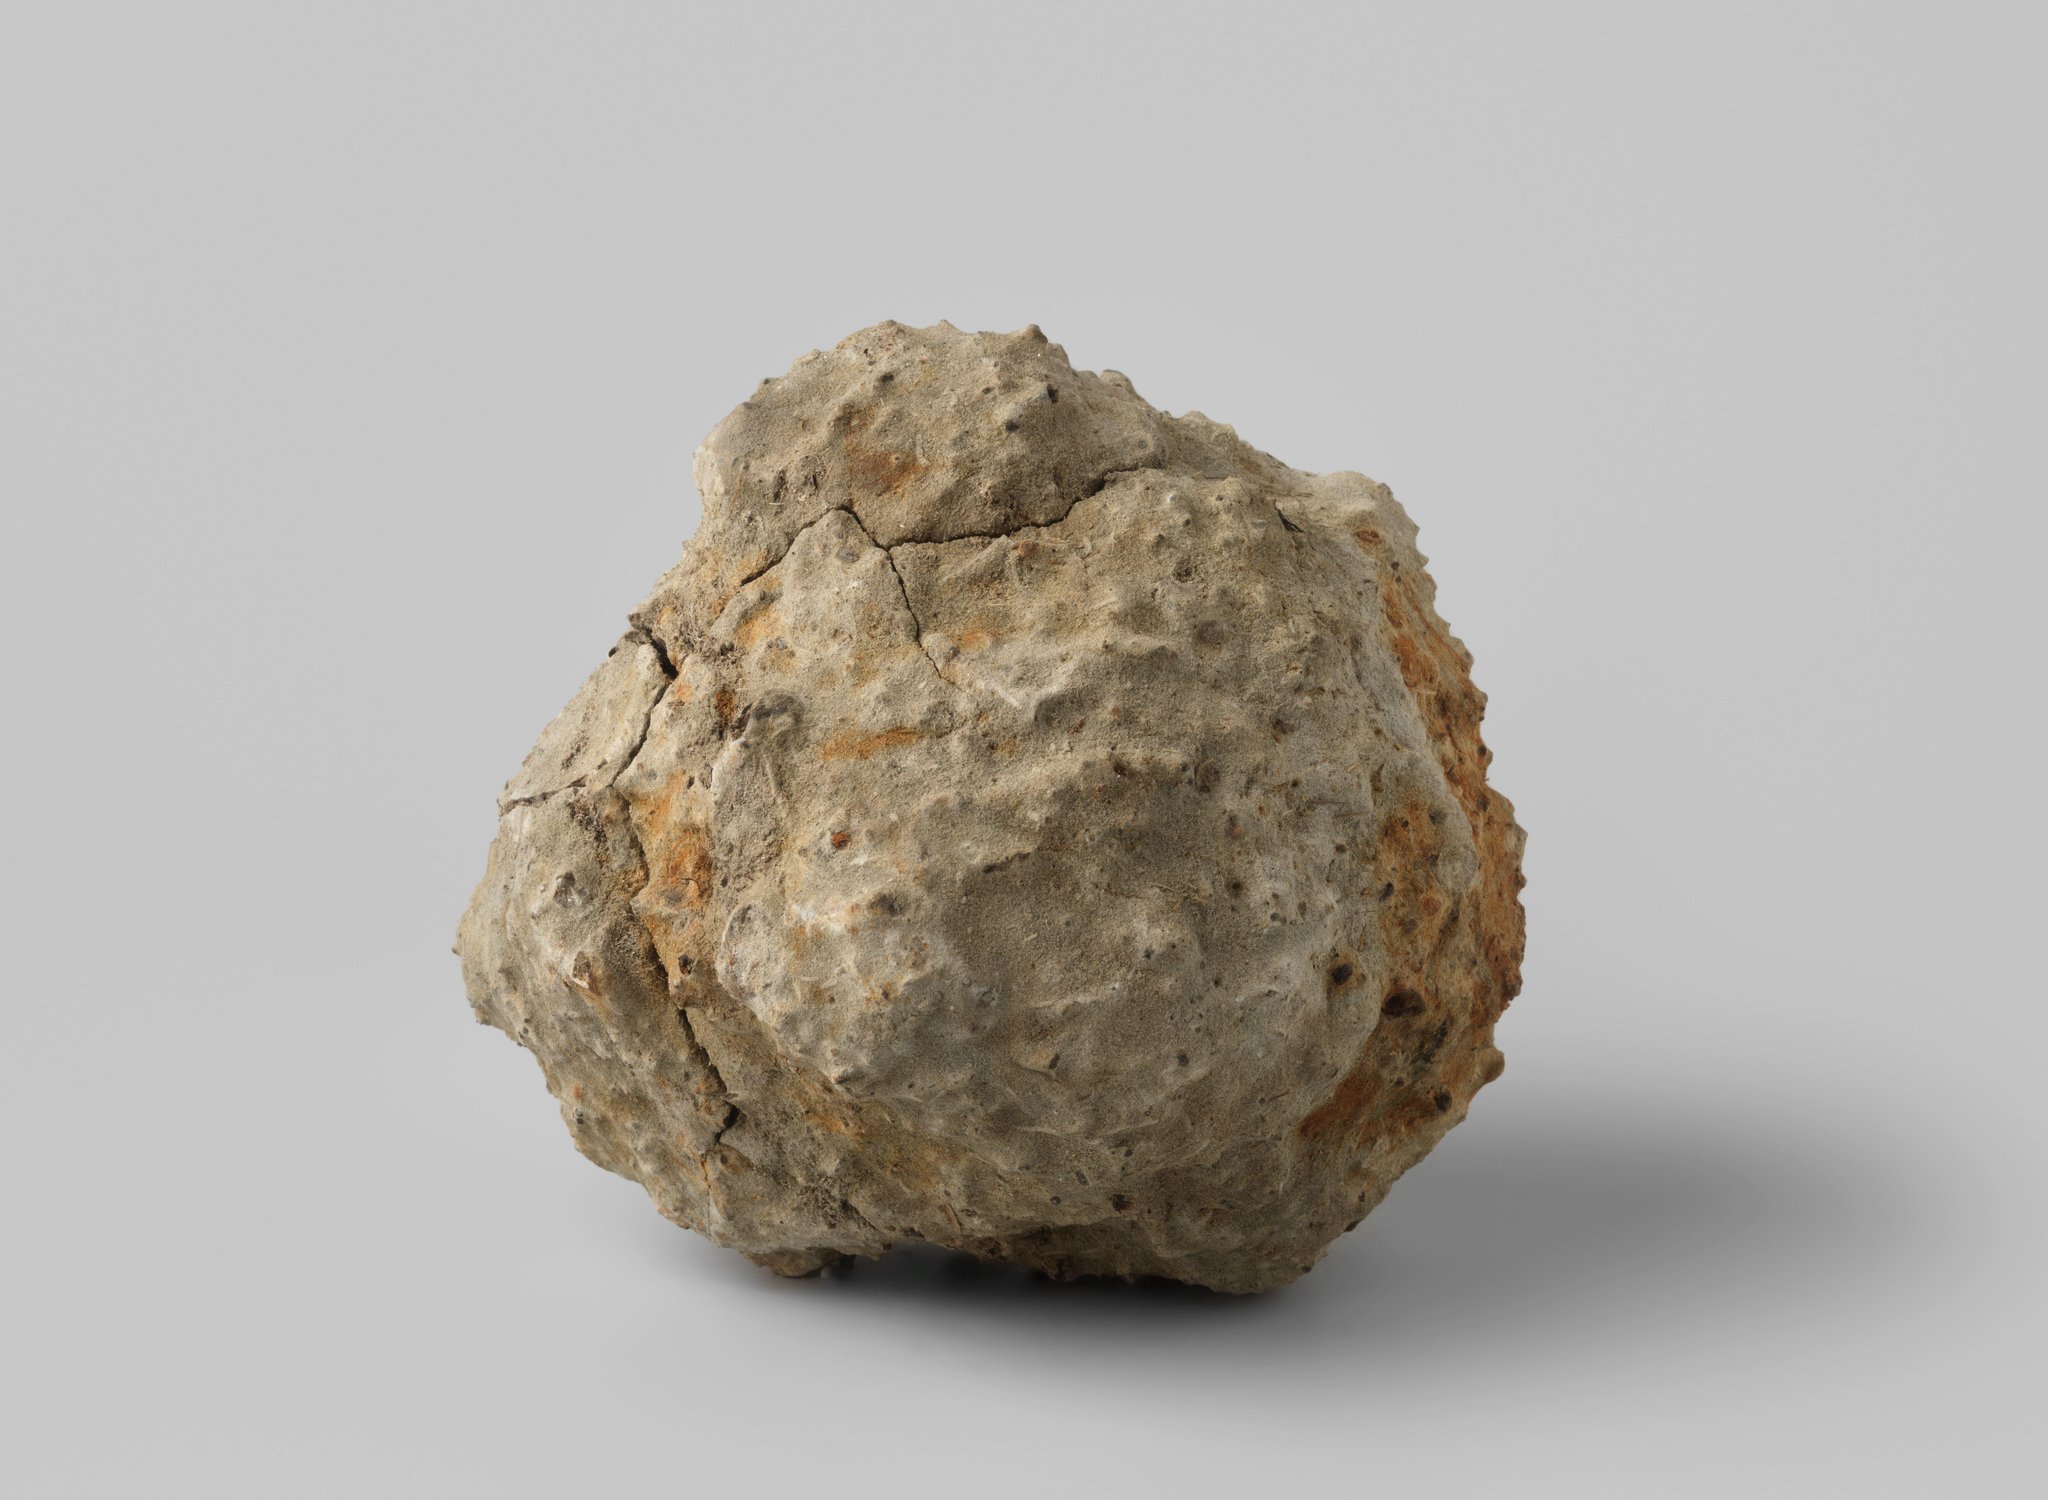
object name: concretionary stone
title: Brok concretie uit V.O.C.-schip de 'Witte Leeuw'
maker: niet van toepassing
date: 1613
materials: stone, iron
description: Brok concretie. Waarschijnlijk gevormd rond kogel.